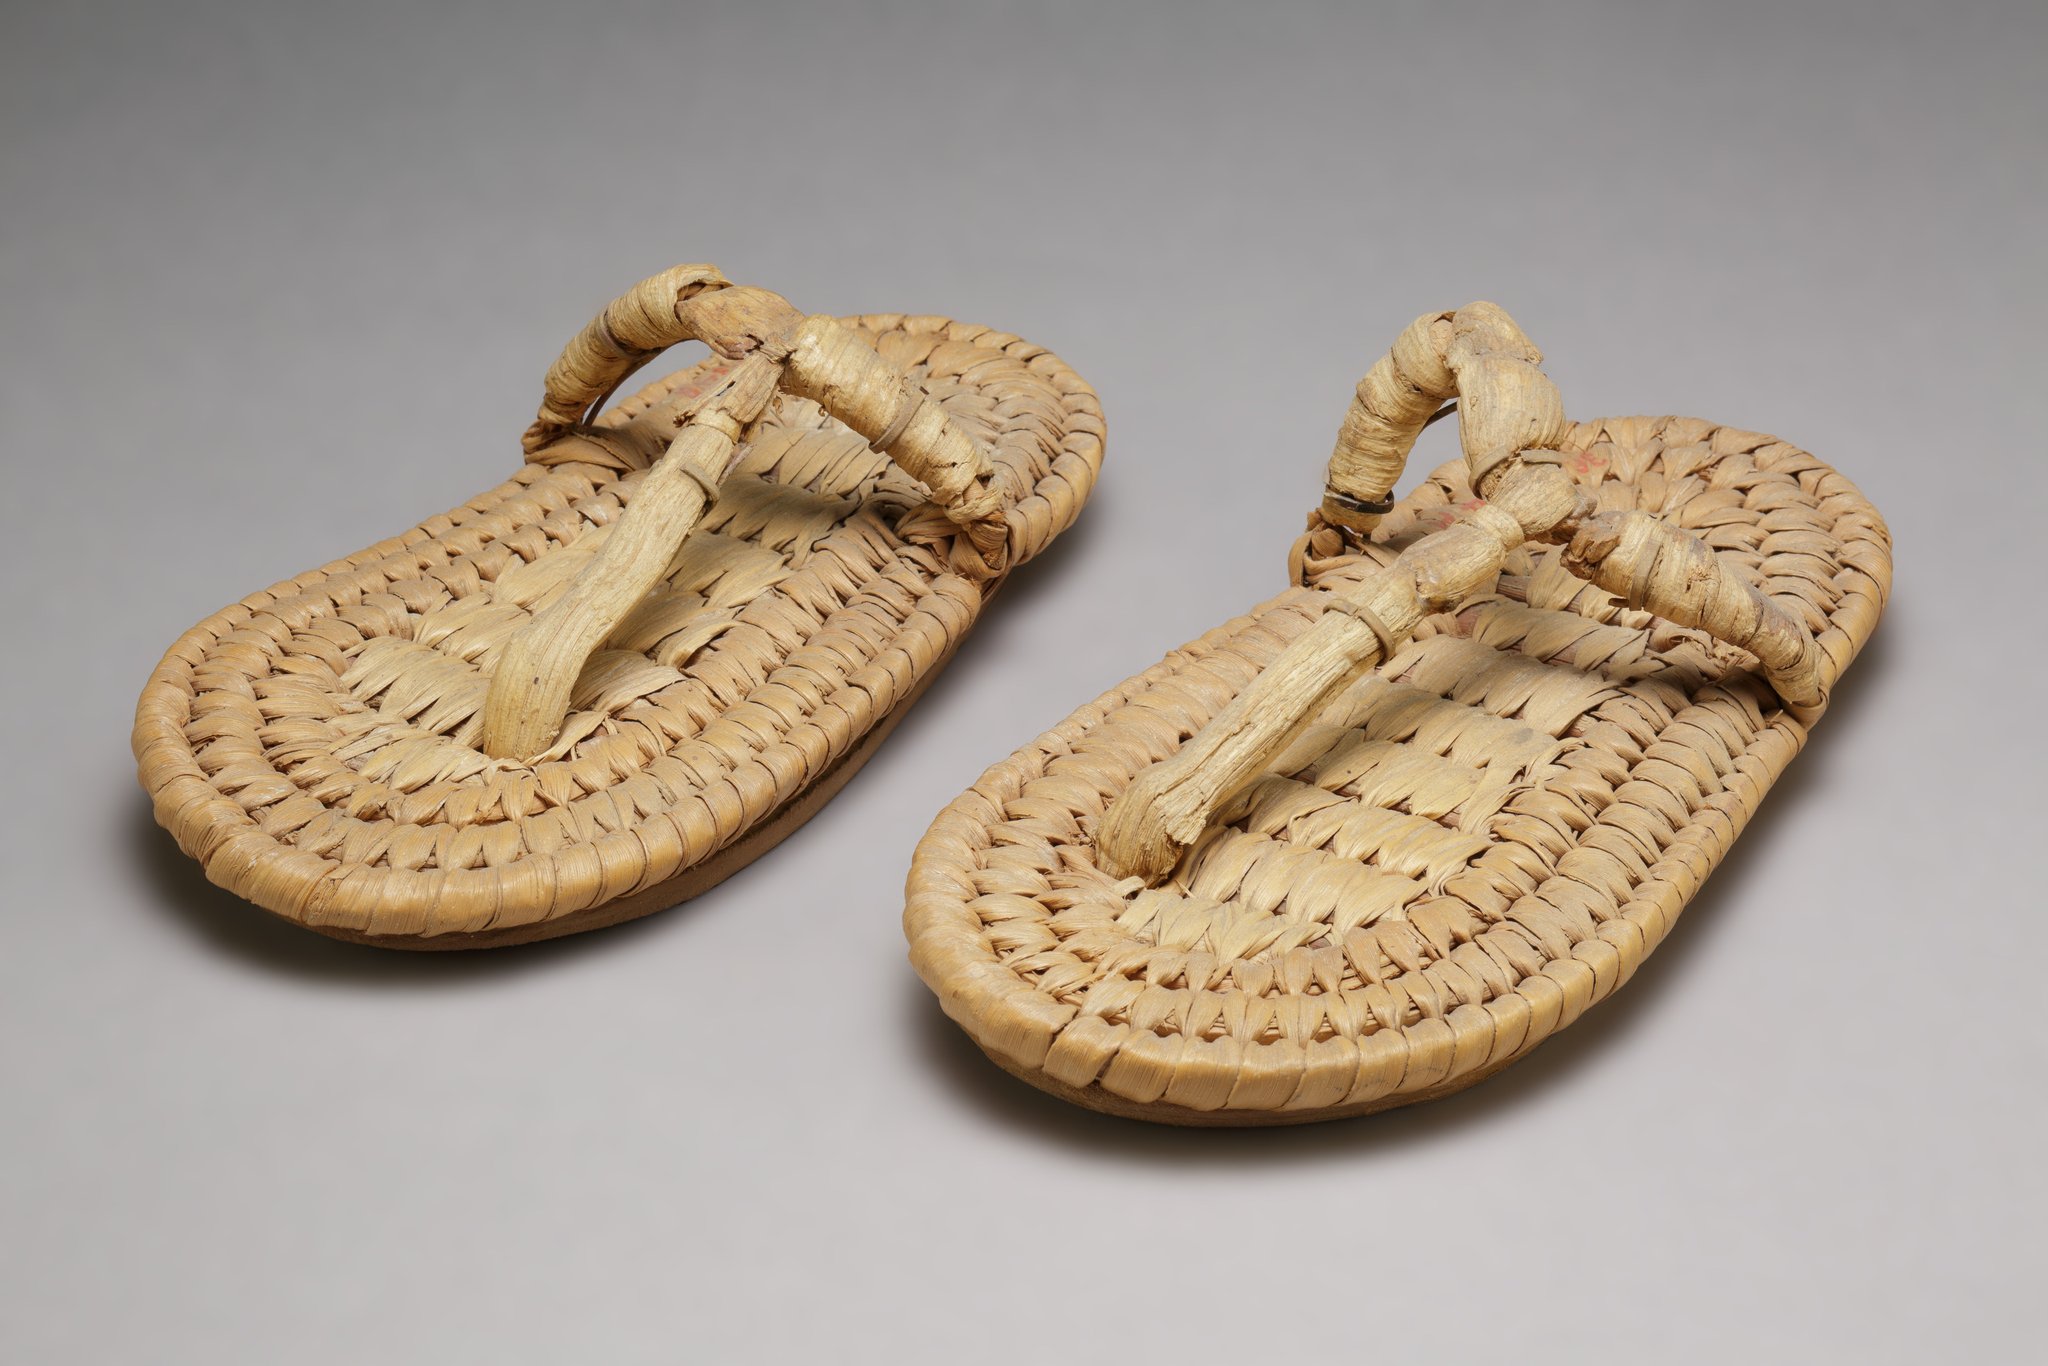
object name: sandal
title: Pair of sandals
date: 1479-1458 BCE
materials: leaf, papyrus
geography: egypt